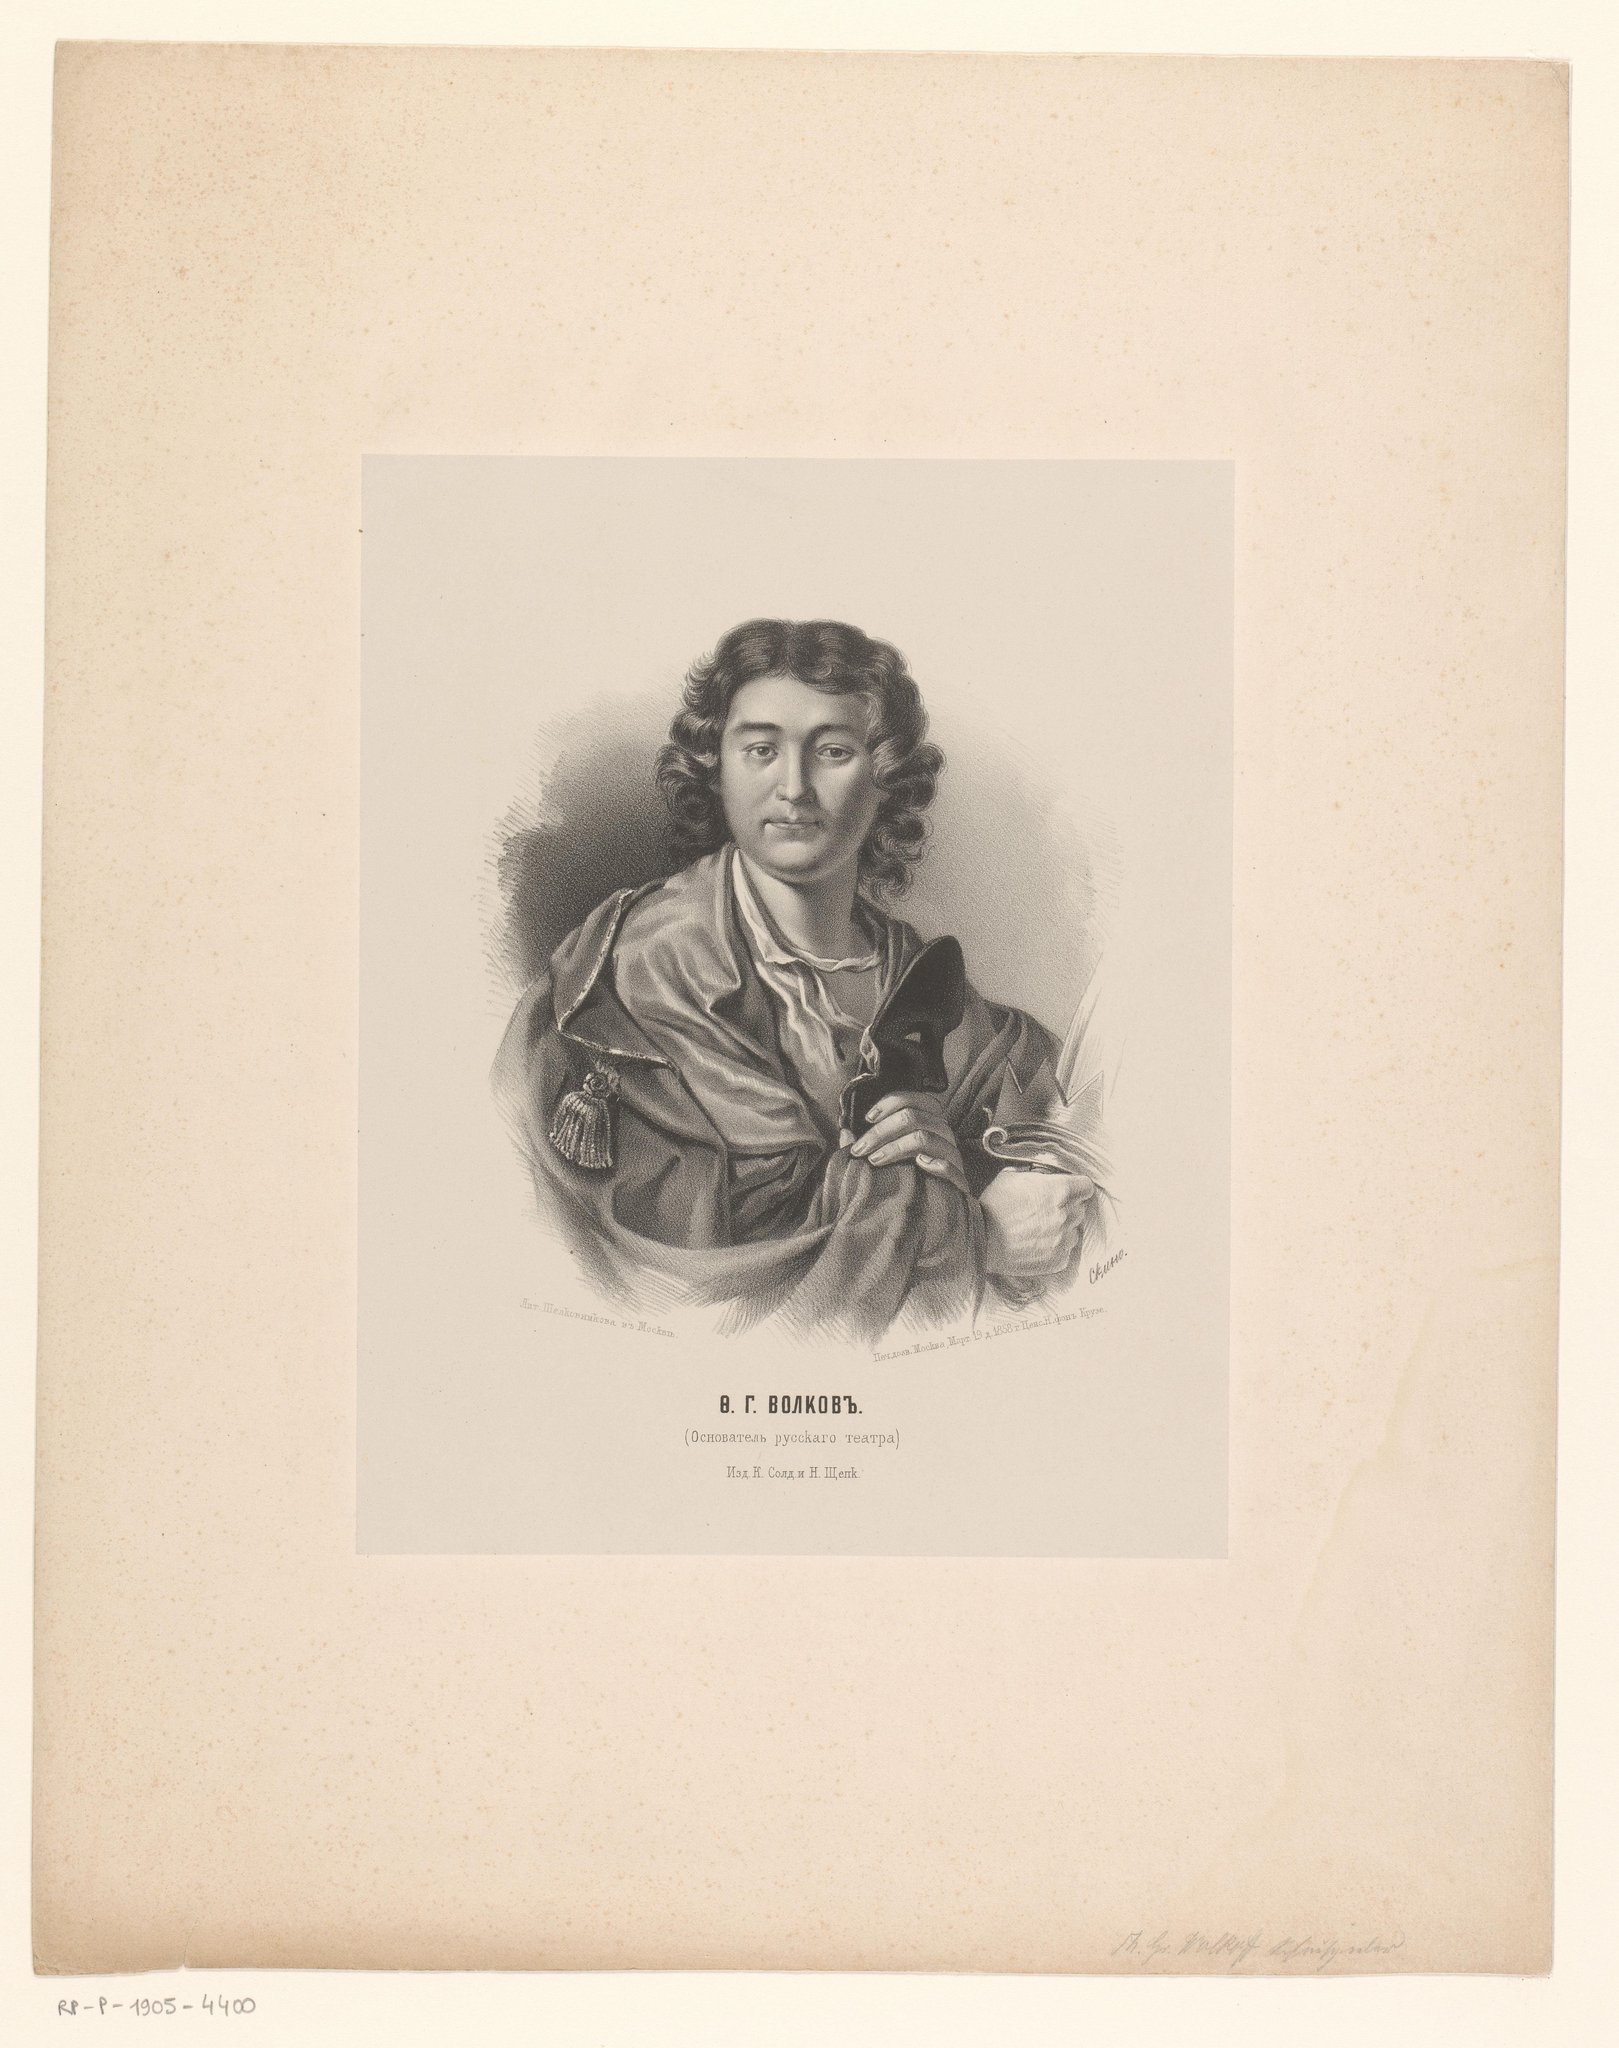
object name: print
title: Portret van een onbekende man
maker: Anonymous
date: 1858-1890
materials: paper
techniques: lithograph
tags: mask, adult man, historical persons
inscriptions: collector's mark: Lugt 2228, mark